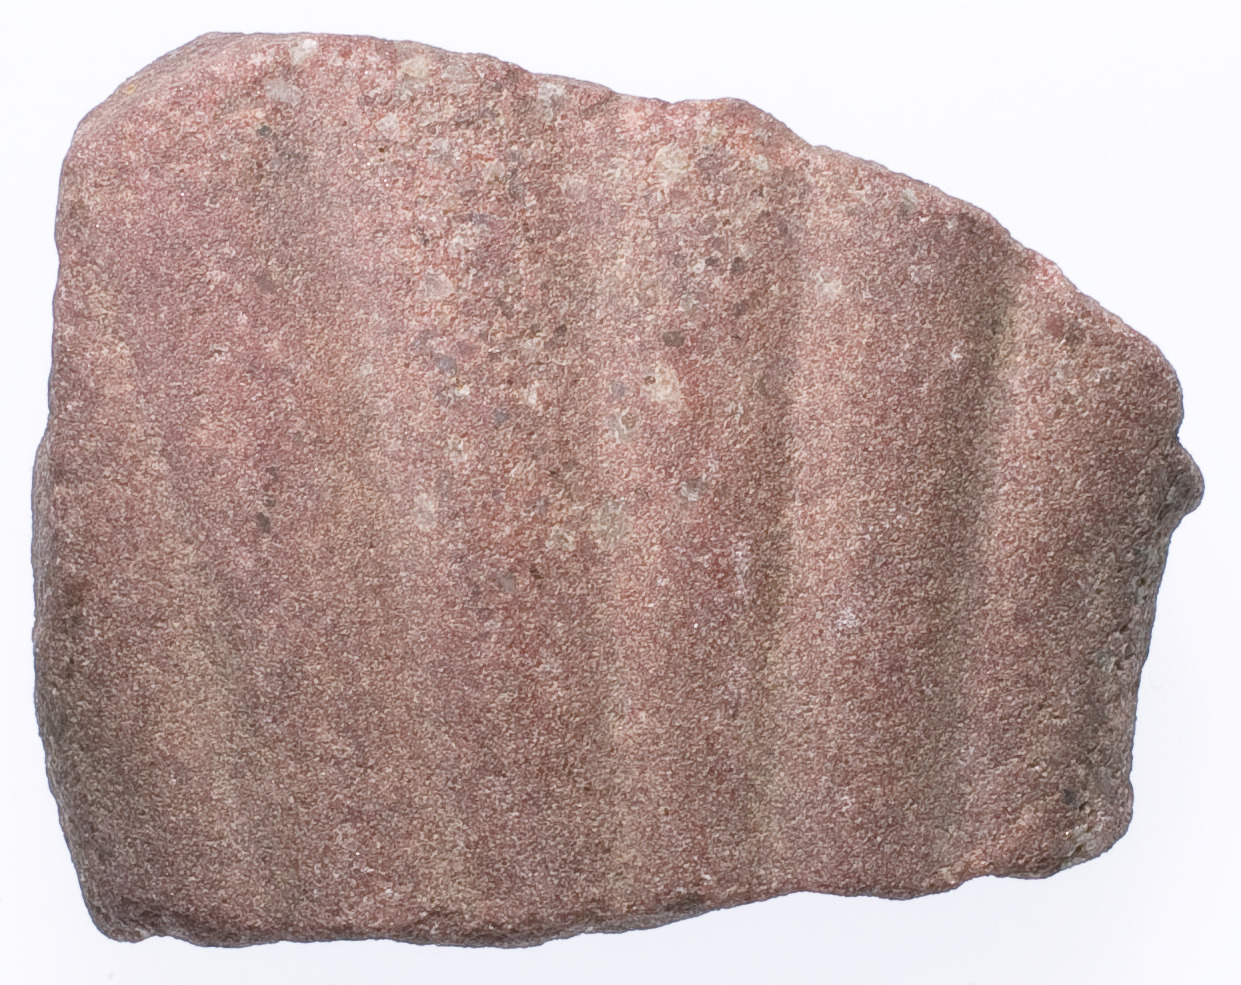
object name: inlay element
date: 1353-1336 BCE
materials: quartzite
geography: egypt